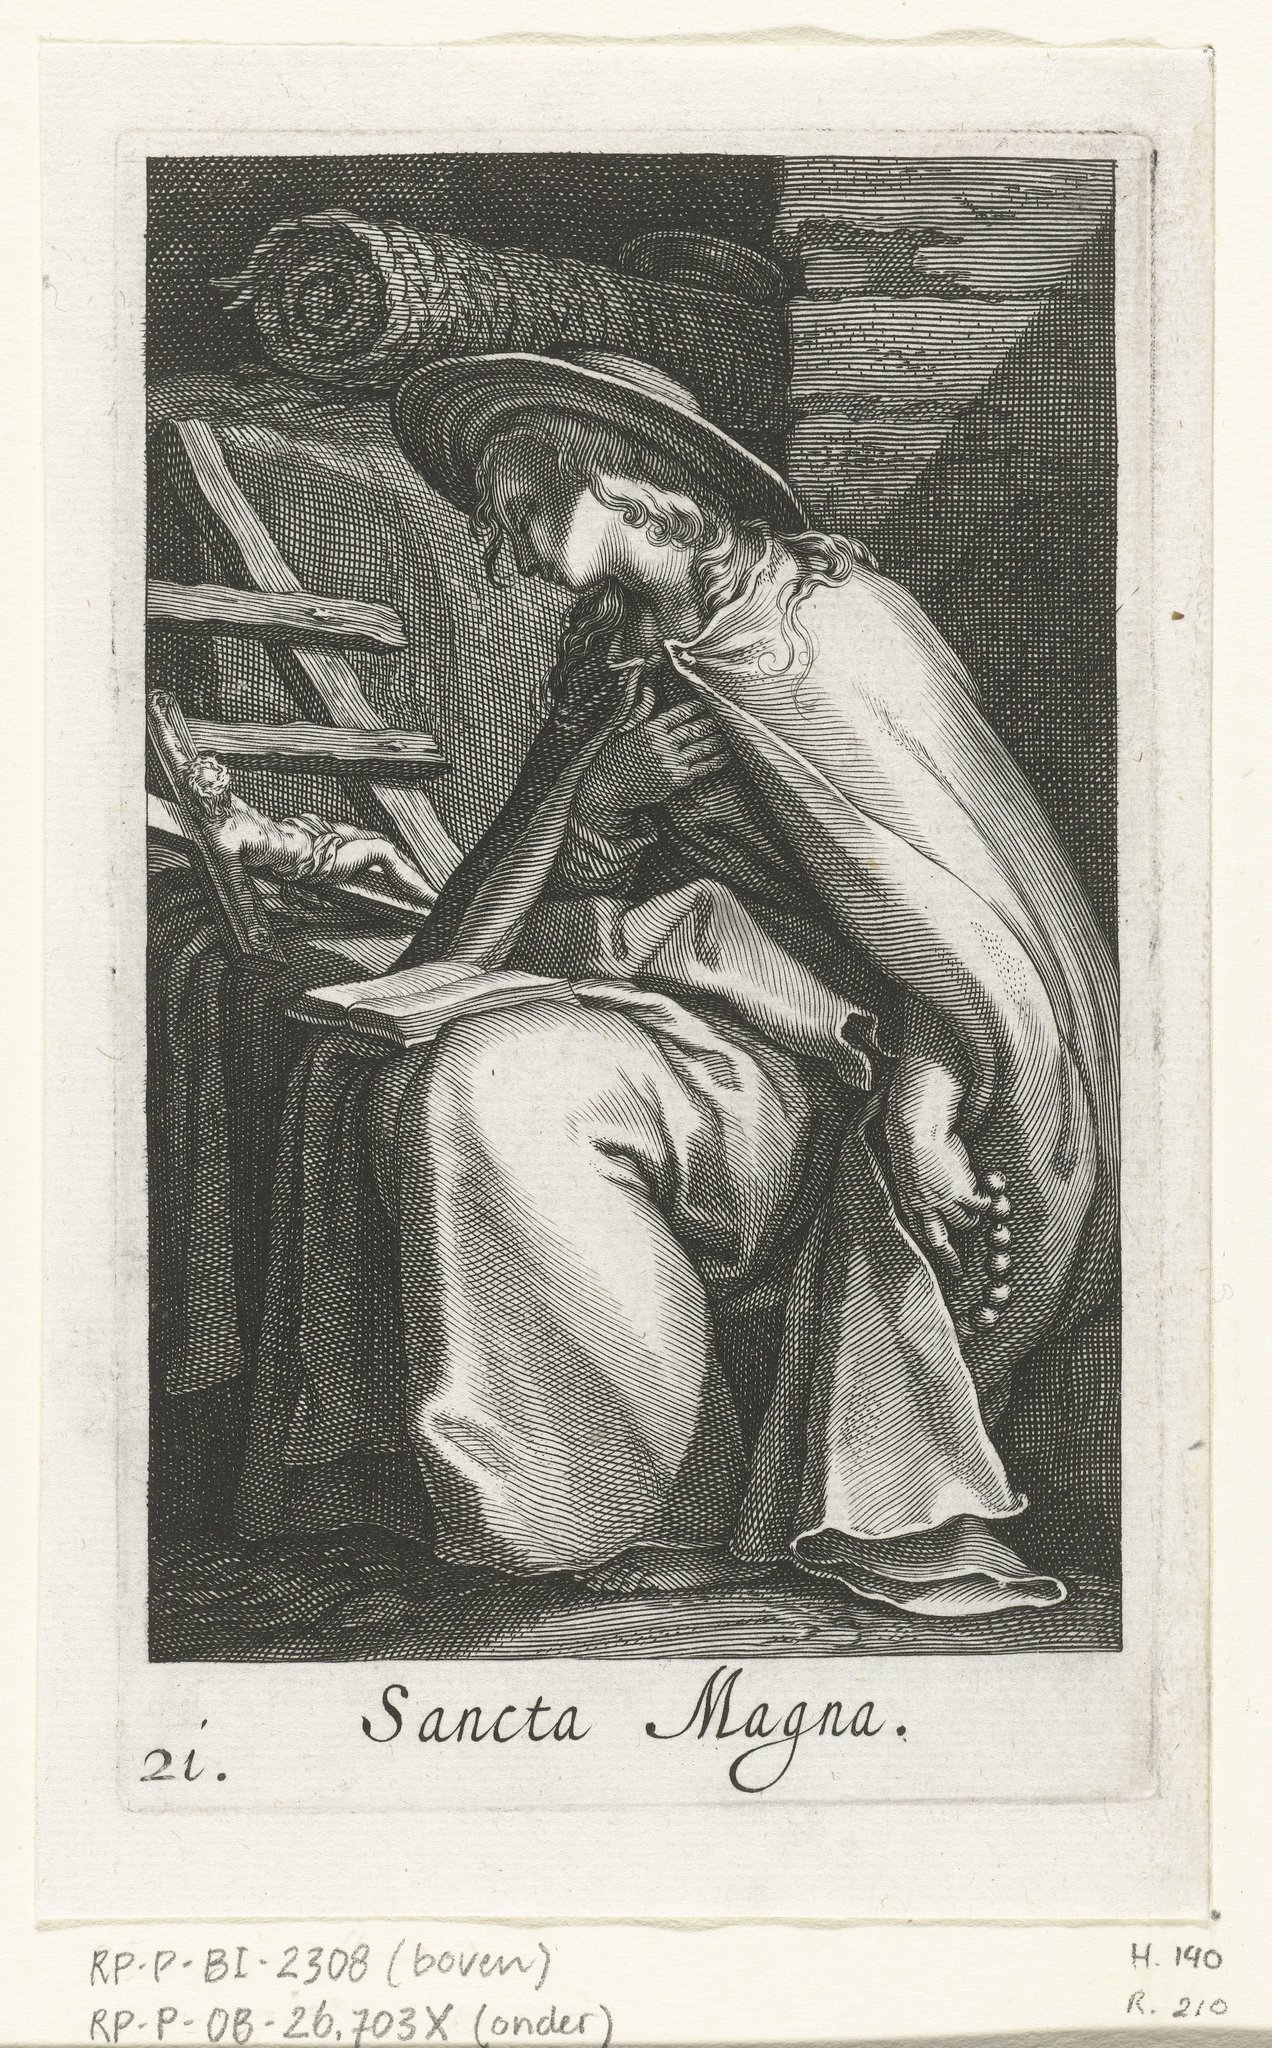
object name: book illustration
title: Kluizenaressen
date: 1590-1612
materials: paper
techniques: engraving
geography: amsterdam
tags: anchorite, hermit, female saints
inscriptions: collector's mark: Lugt 2228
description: Prent uit: Sacra Eremus Ascetriarum, uitgever Boëtius Adamsz. Bolswert, 1612 of Hendrik Aertssen, Antwerpen 1619. Prent uit de serie van vijfentwintig kluizenaressen in deze uitgaven. In 1612 verscheen een ongebonden editie maar op basis van de gewijzigde opschriften en samenstelling van de serie kluizenaars wordt aangenomen dat de prenten van de uitgave 1619 ook in 1612 of iets daarvoor gedrukt werden. De serie kluizenaressen bleef vrijwel ongewijzigd in de ongebonden uitgave van 1612, dit compliceert de datering van de losse bladen in de collectie van het RMA, zie Roethlisberger 1993, p. 171-175.